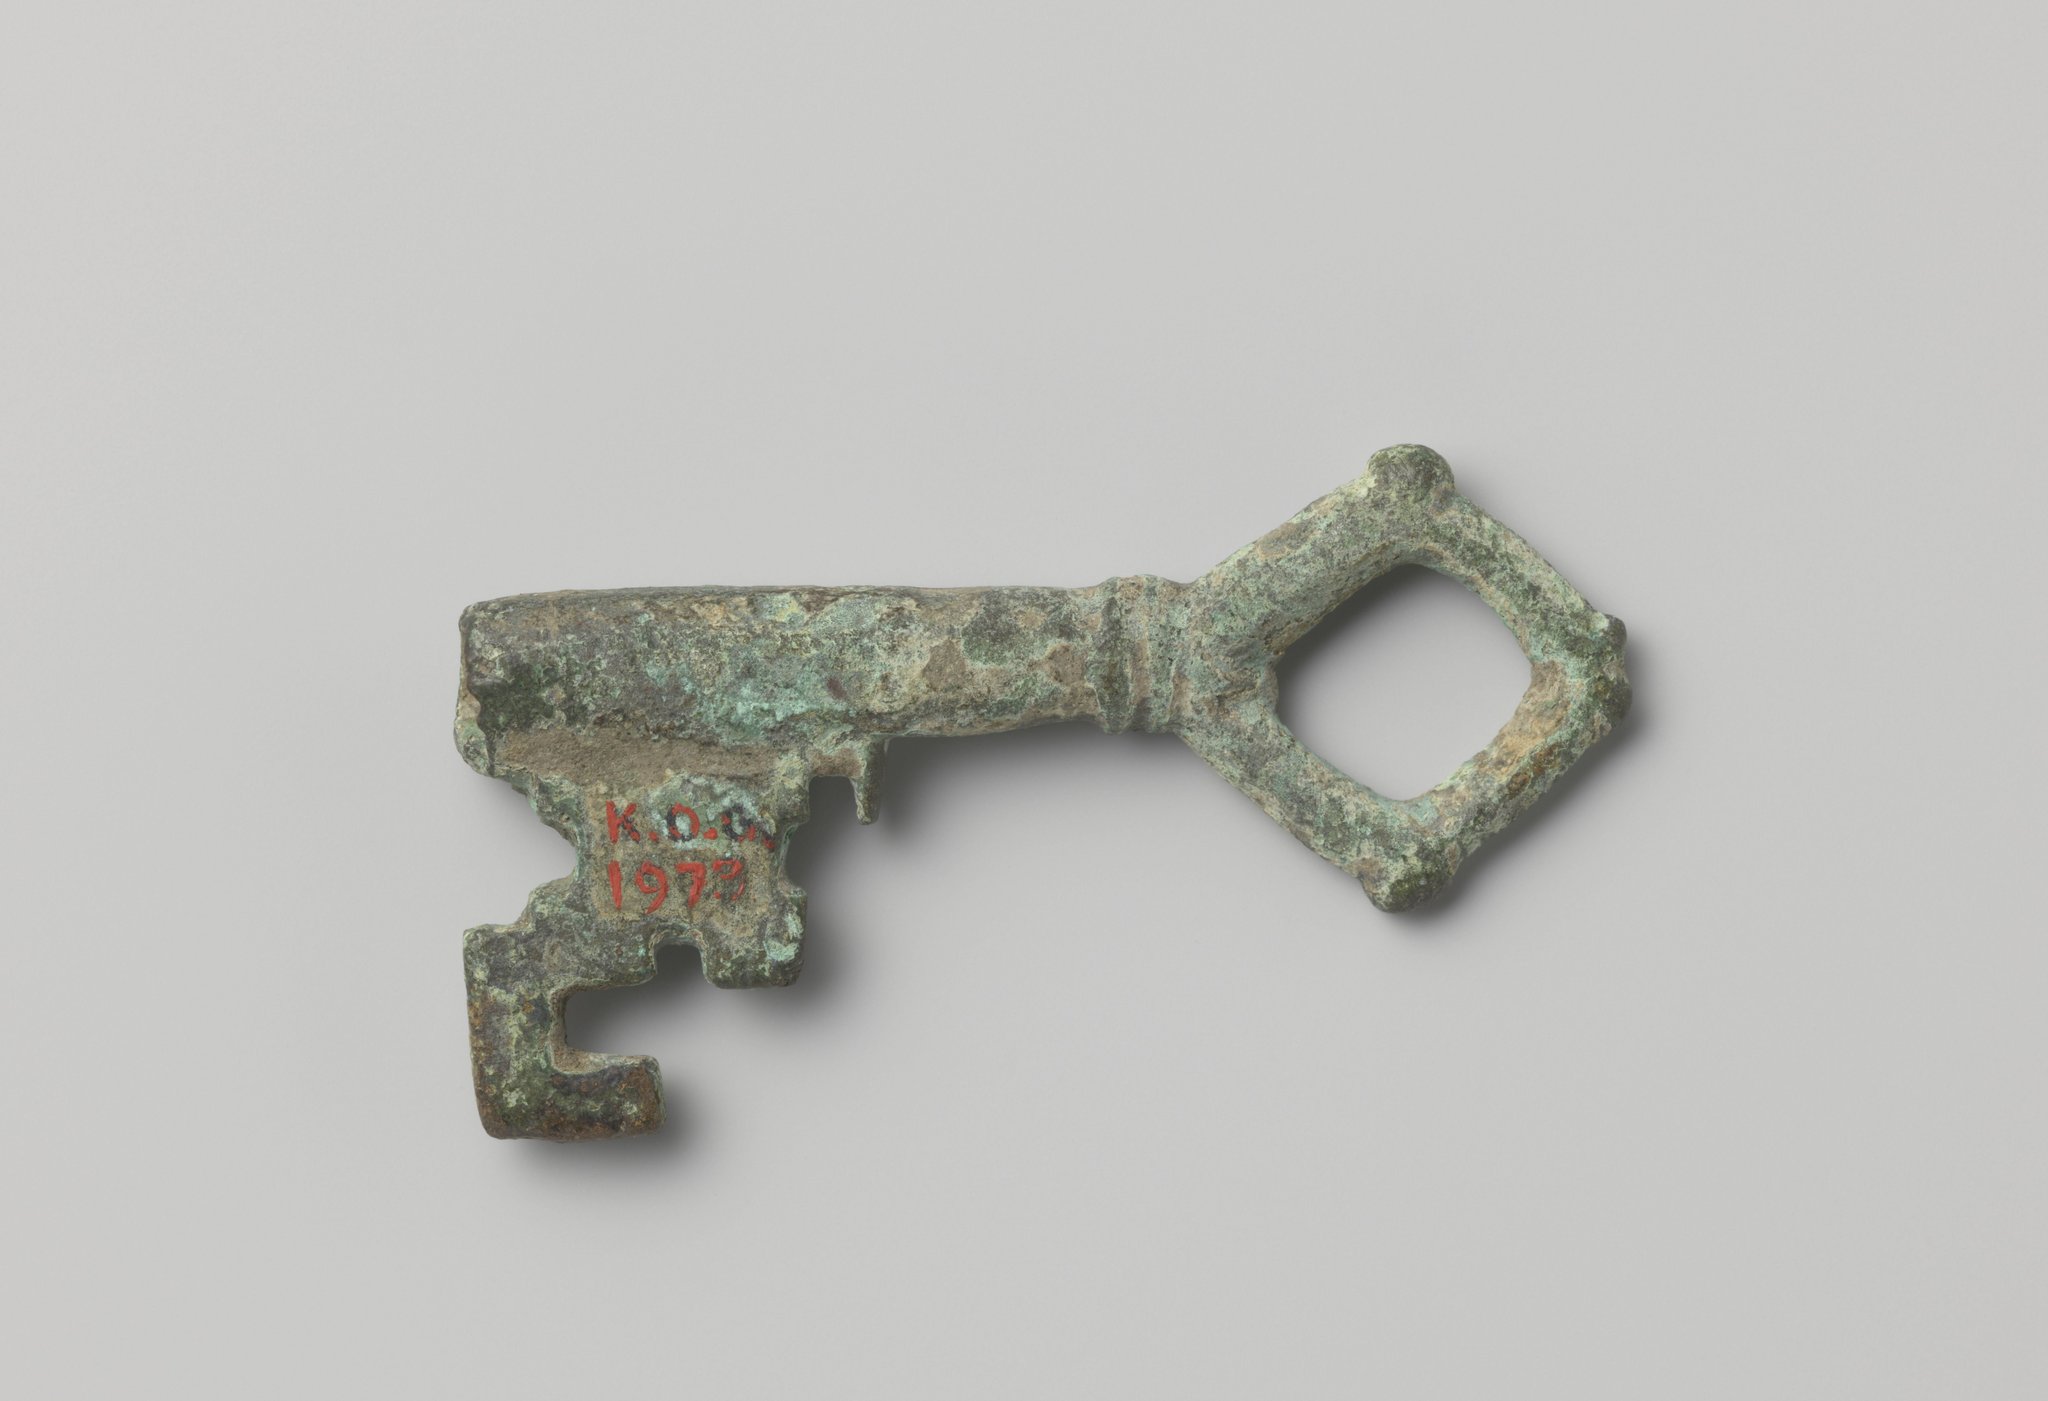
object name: pipe key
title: 39 keys from the collection of Emmanuel Vita Israël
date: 1200-1300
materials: bronze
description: The Amsterdam apothecary and art collector Emmanuel Vita Israël. He donated his collection, comprising keys dating from Roman antiquity to the 19th century, to the Koninklijk Oudheidkundig Genootschap (Royal Antiquarian Society) in 1937. Vita Israël claimed that his key collection had grown more or less by accident: being one of the few collectors of keys, dealers automatically made their way to him.